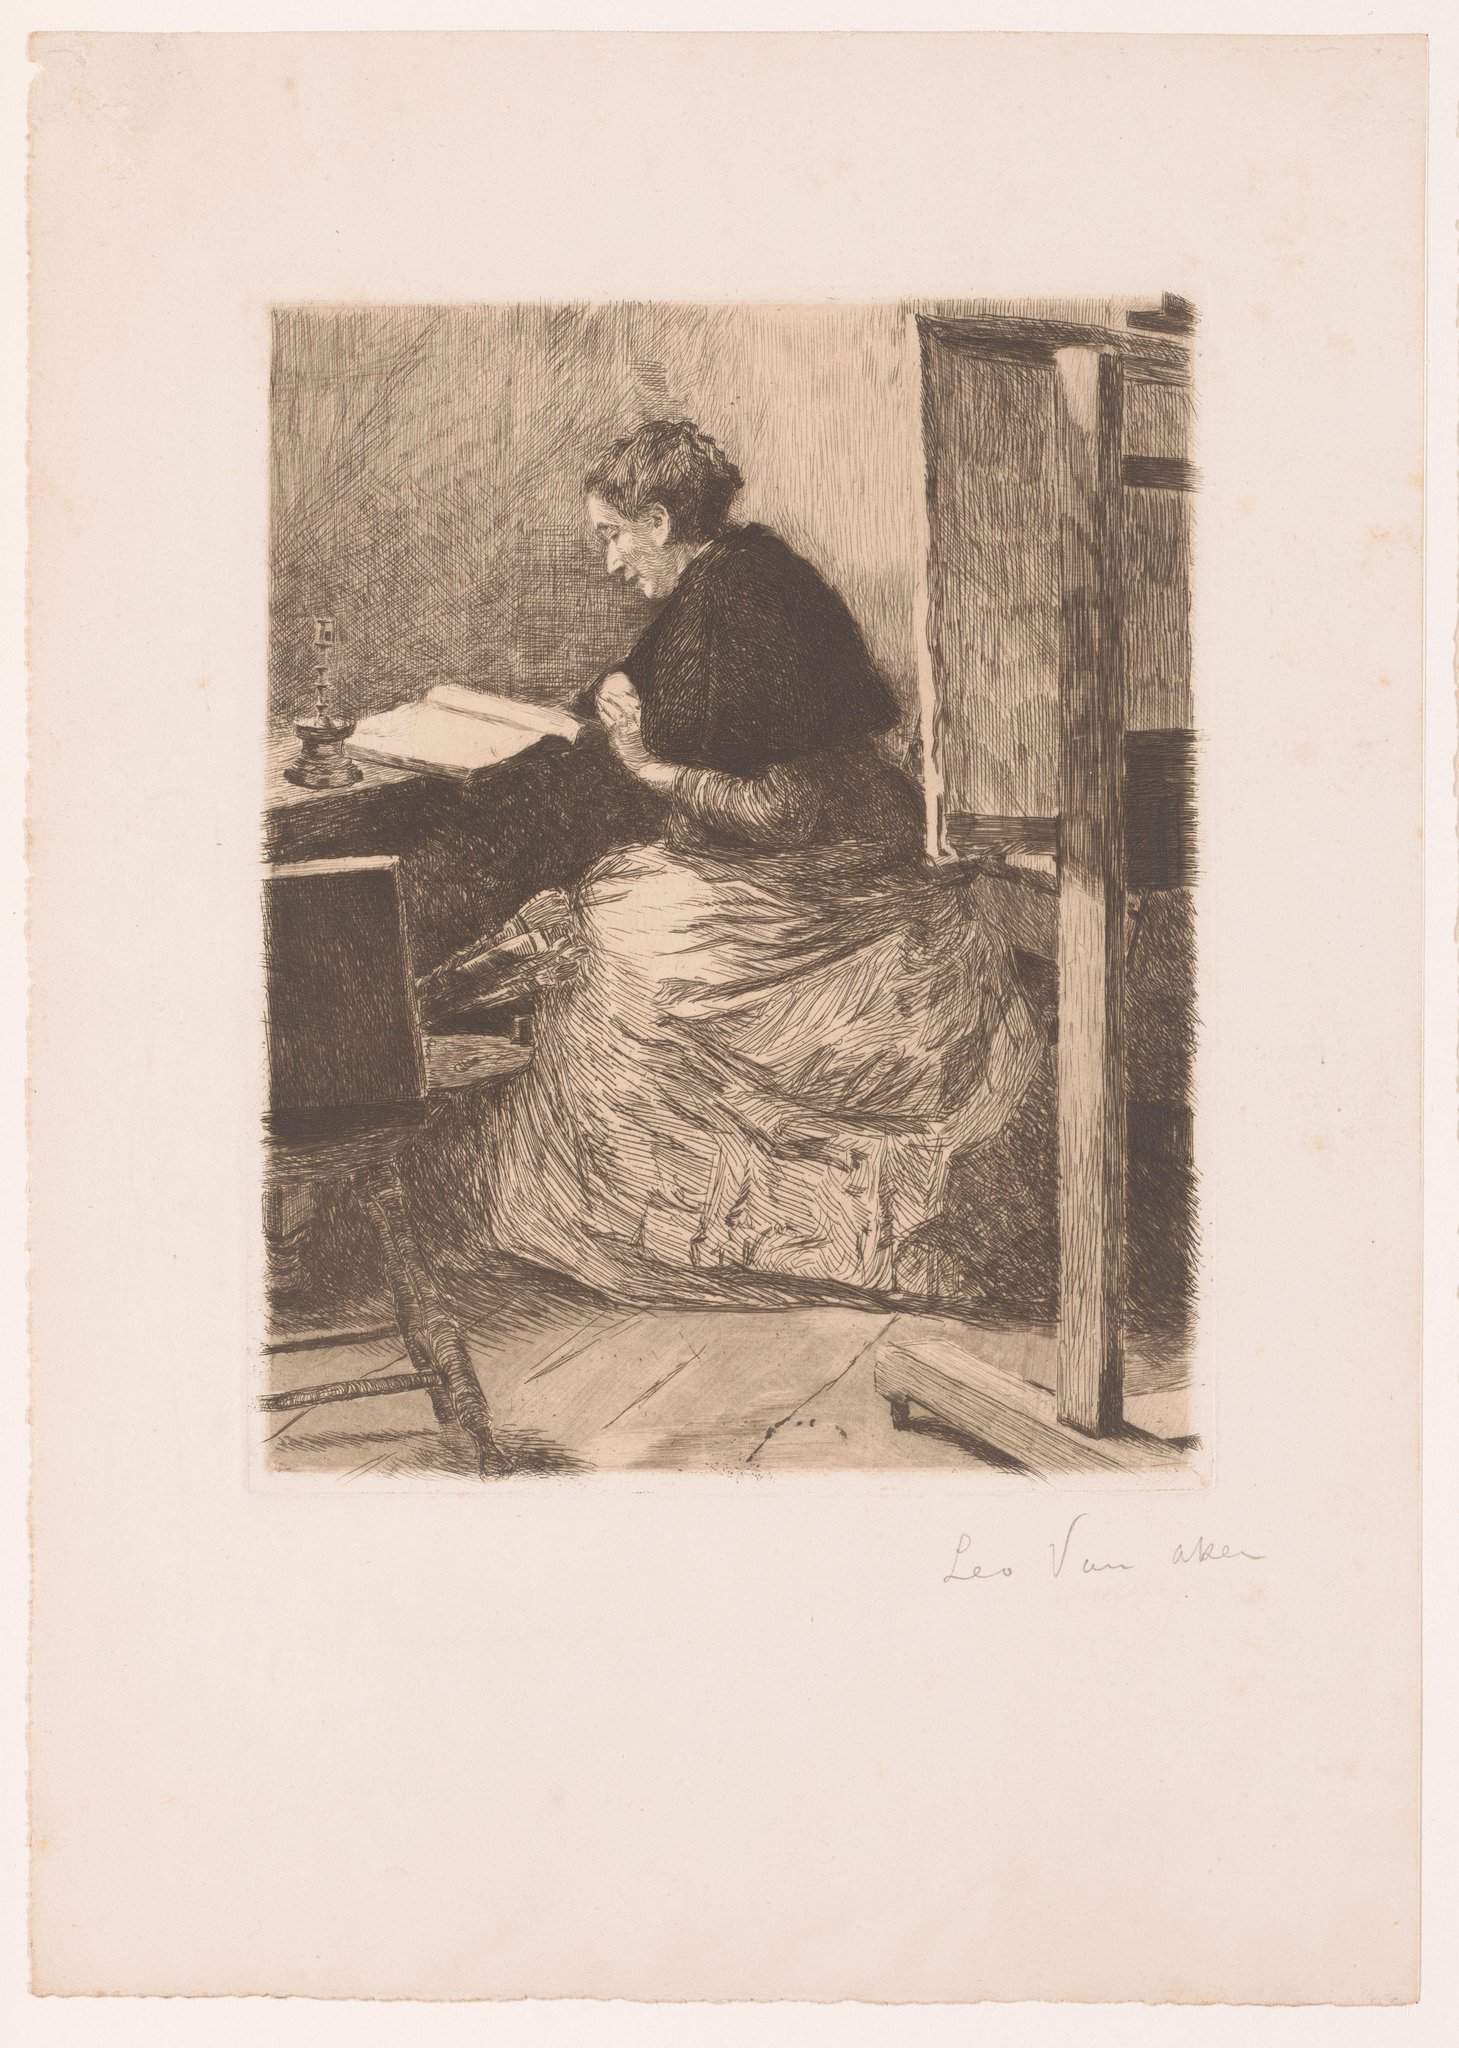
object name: print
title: Lezende vrouw aan een tafel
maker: leo van aken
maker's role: print maker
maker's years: 1857-1904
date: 1867-1904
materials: paper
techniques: drypoint, etching, intaglio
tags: adult woman, reading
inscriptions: collector's mark: Lugt 2228